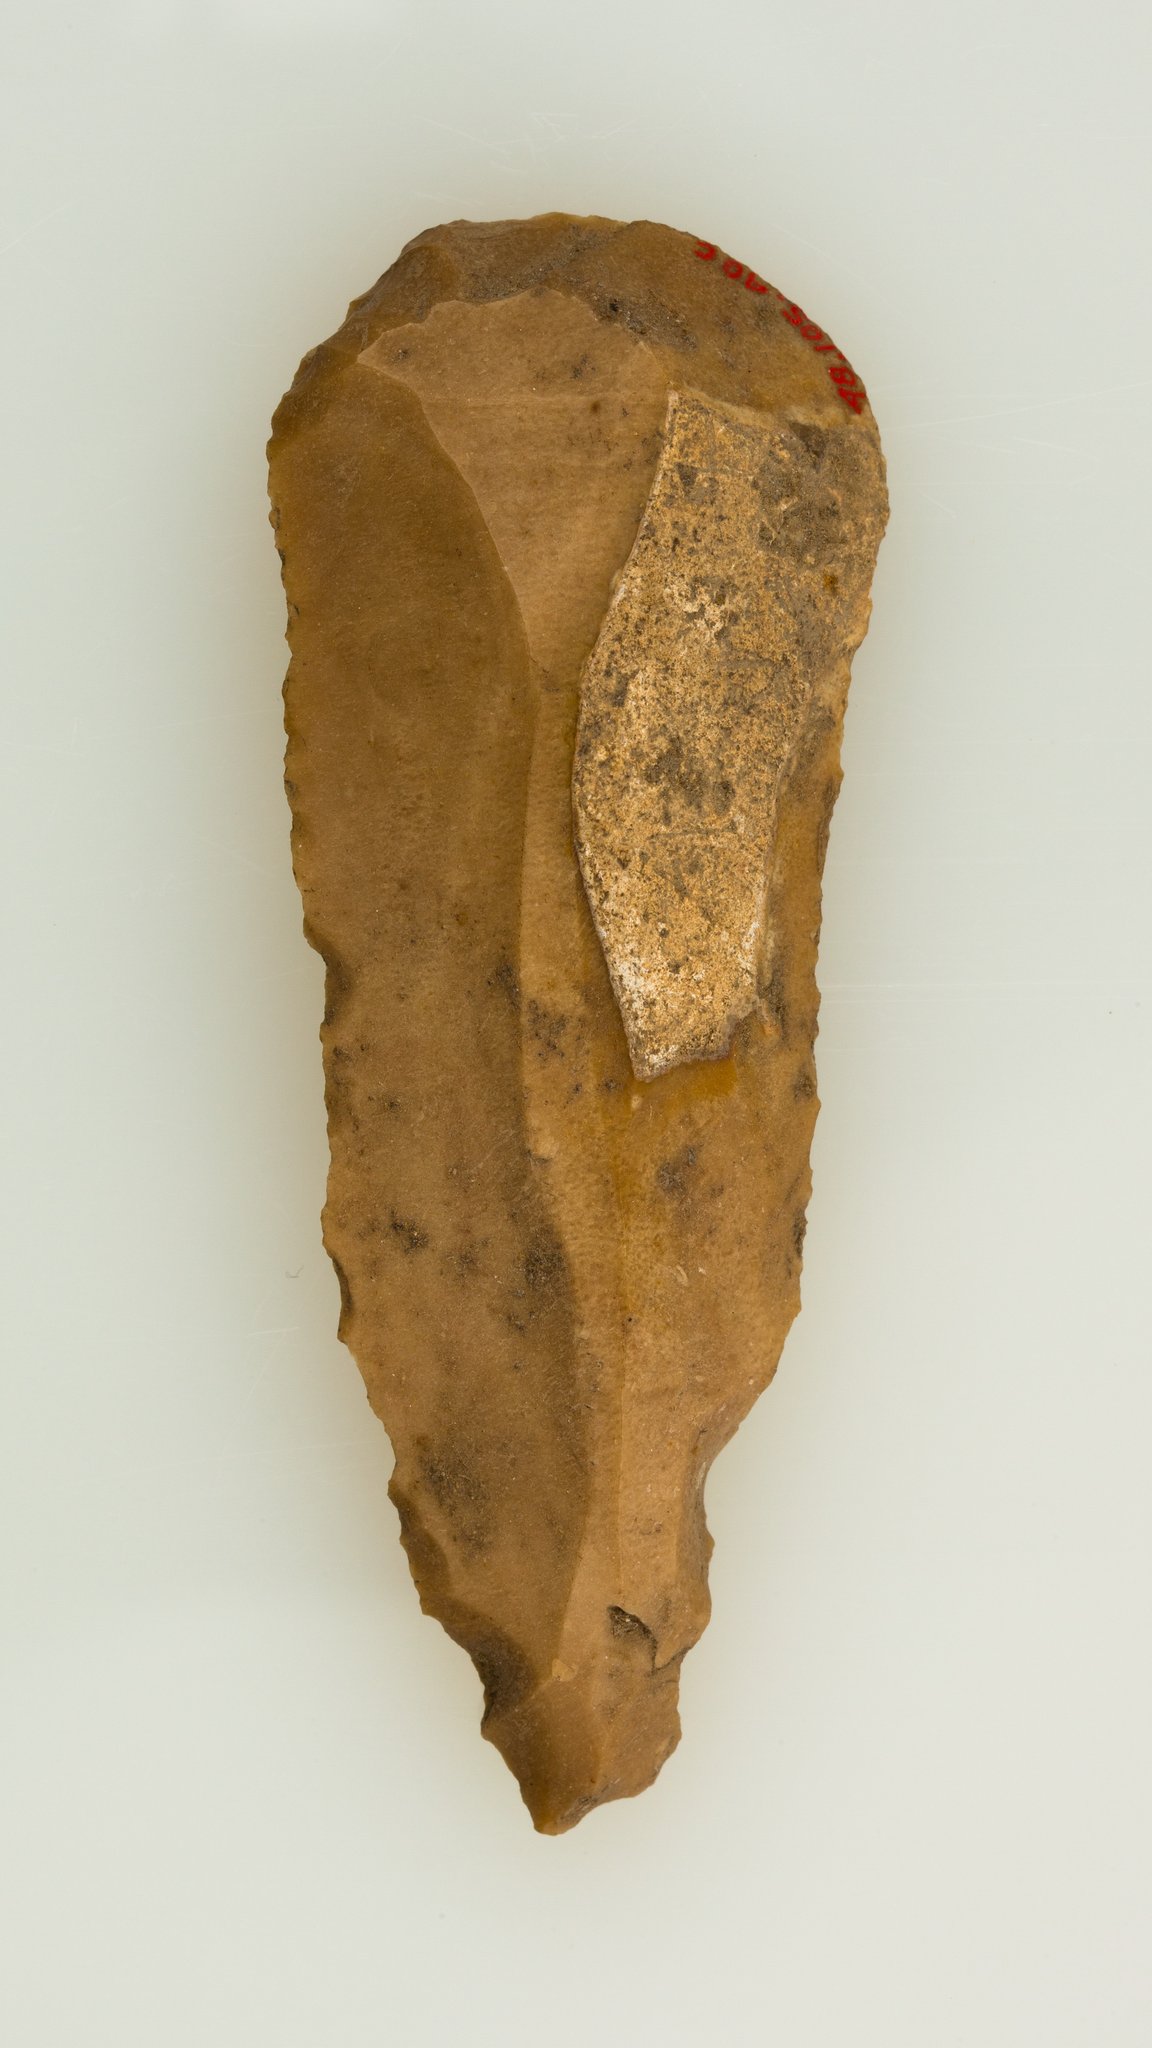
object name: scraper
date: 1184-664 BCE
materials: stone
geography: egypt